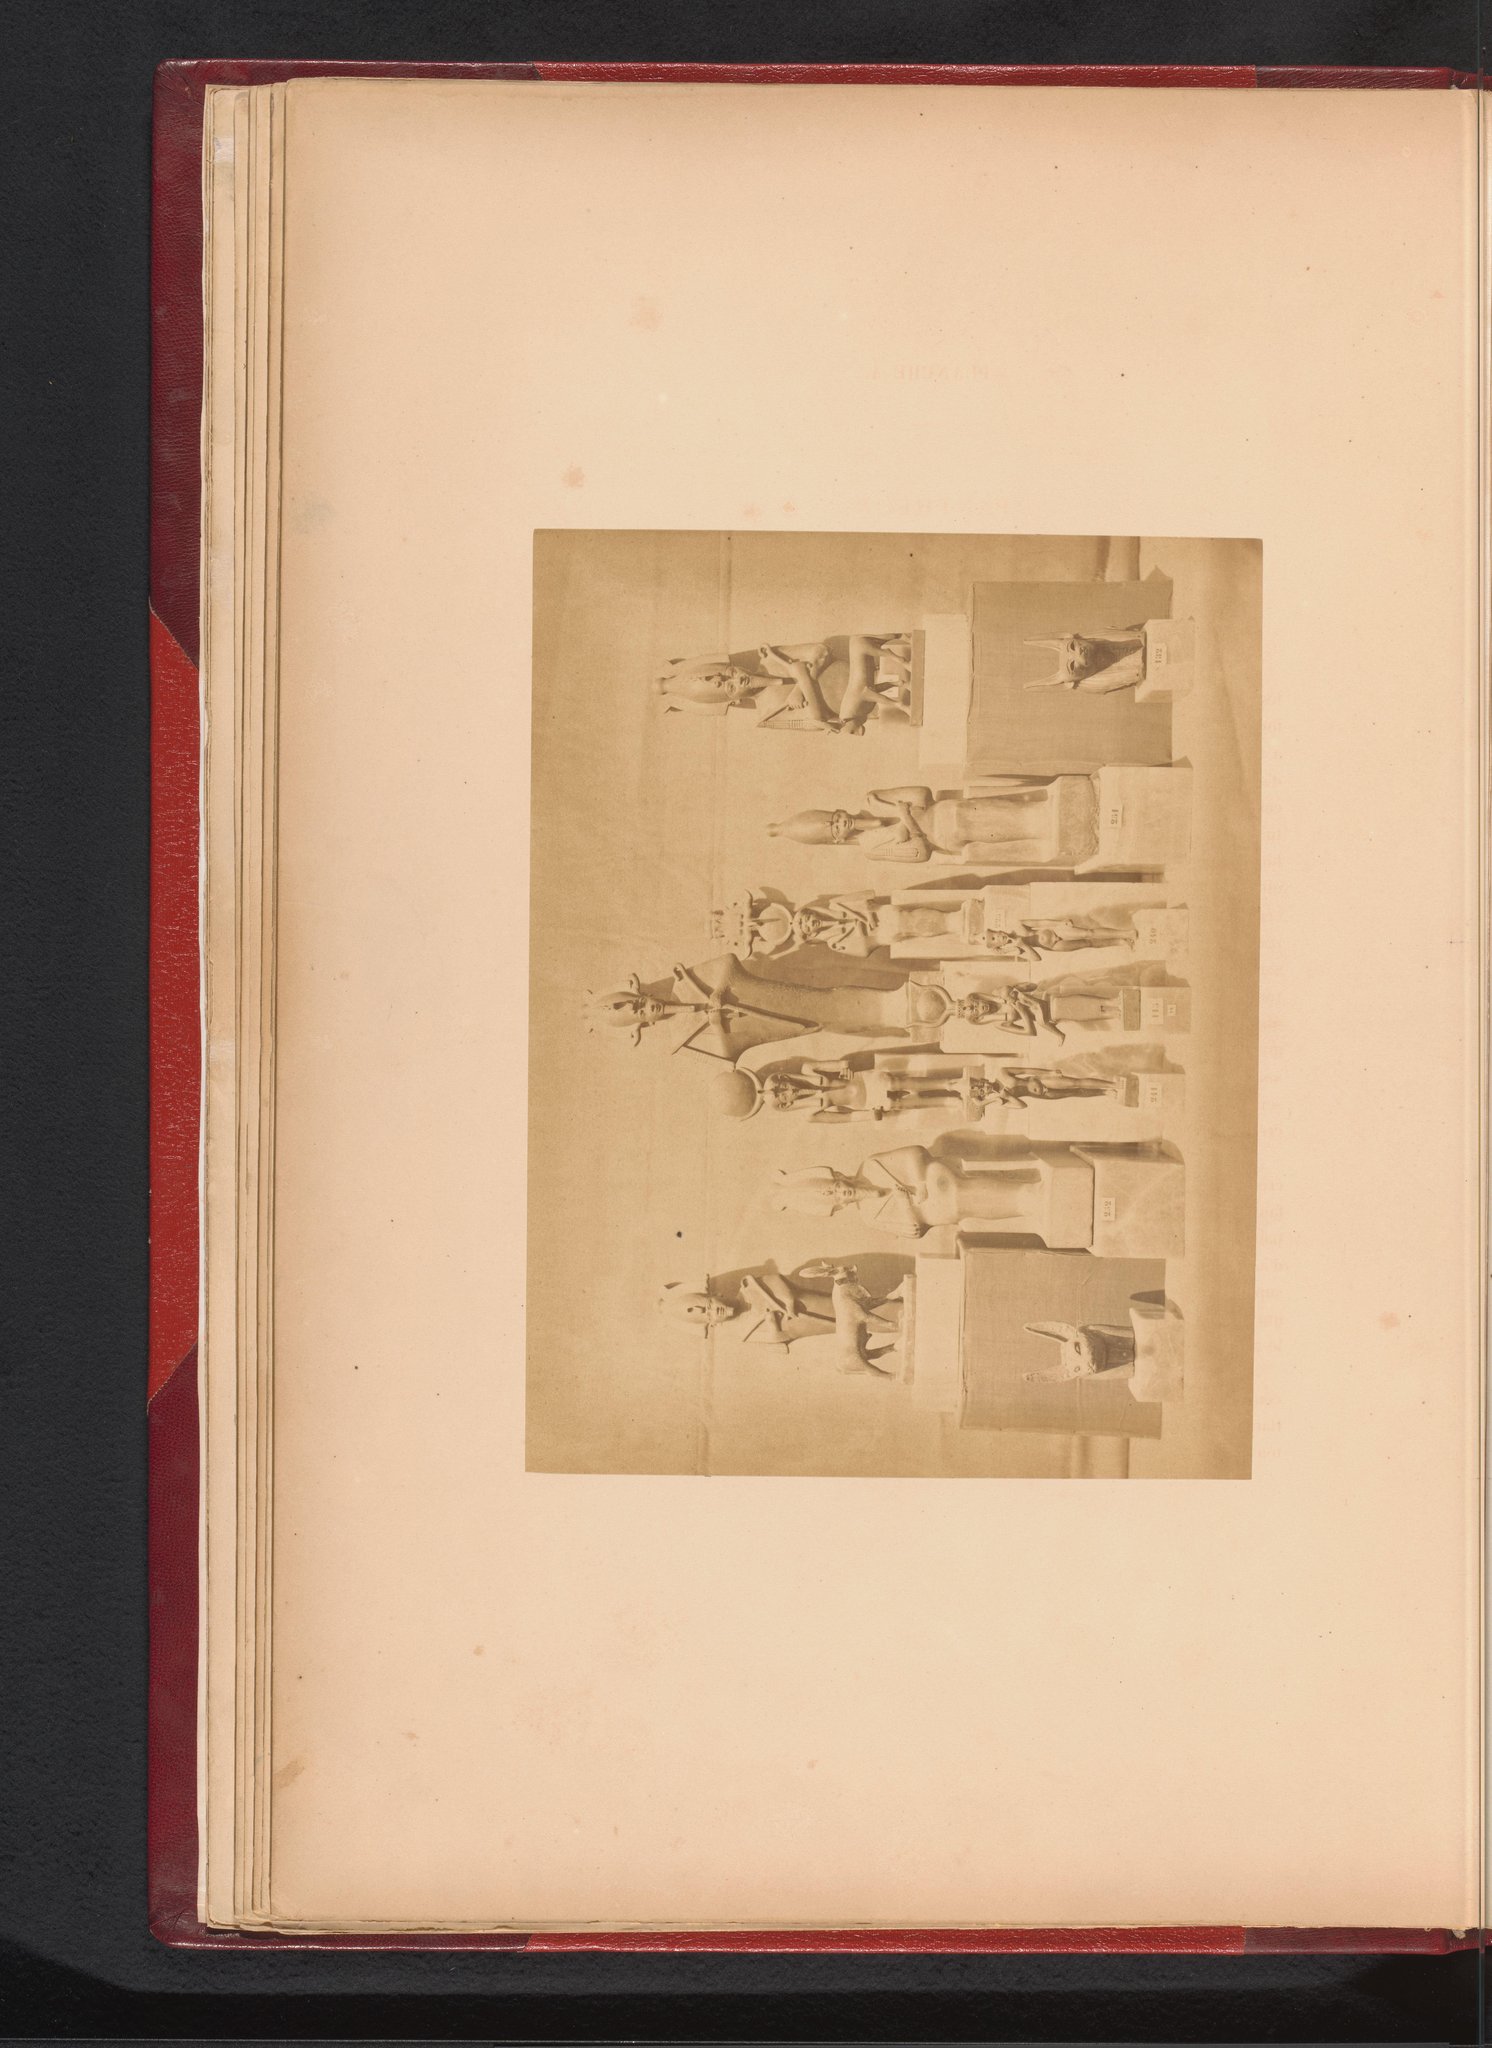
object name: page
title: Beelden van Osiris en andere Egyptische goden in het Boulaq Museum in Caïro, Egypte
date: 1866-1871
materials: photographic support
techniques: albumen print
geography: cairo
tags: statues, paintings, etc. ~ objects of worship (egyptian religion), osiris, god of the underworld, permanent exhibition, museum